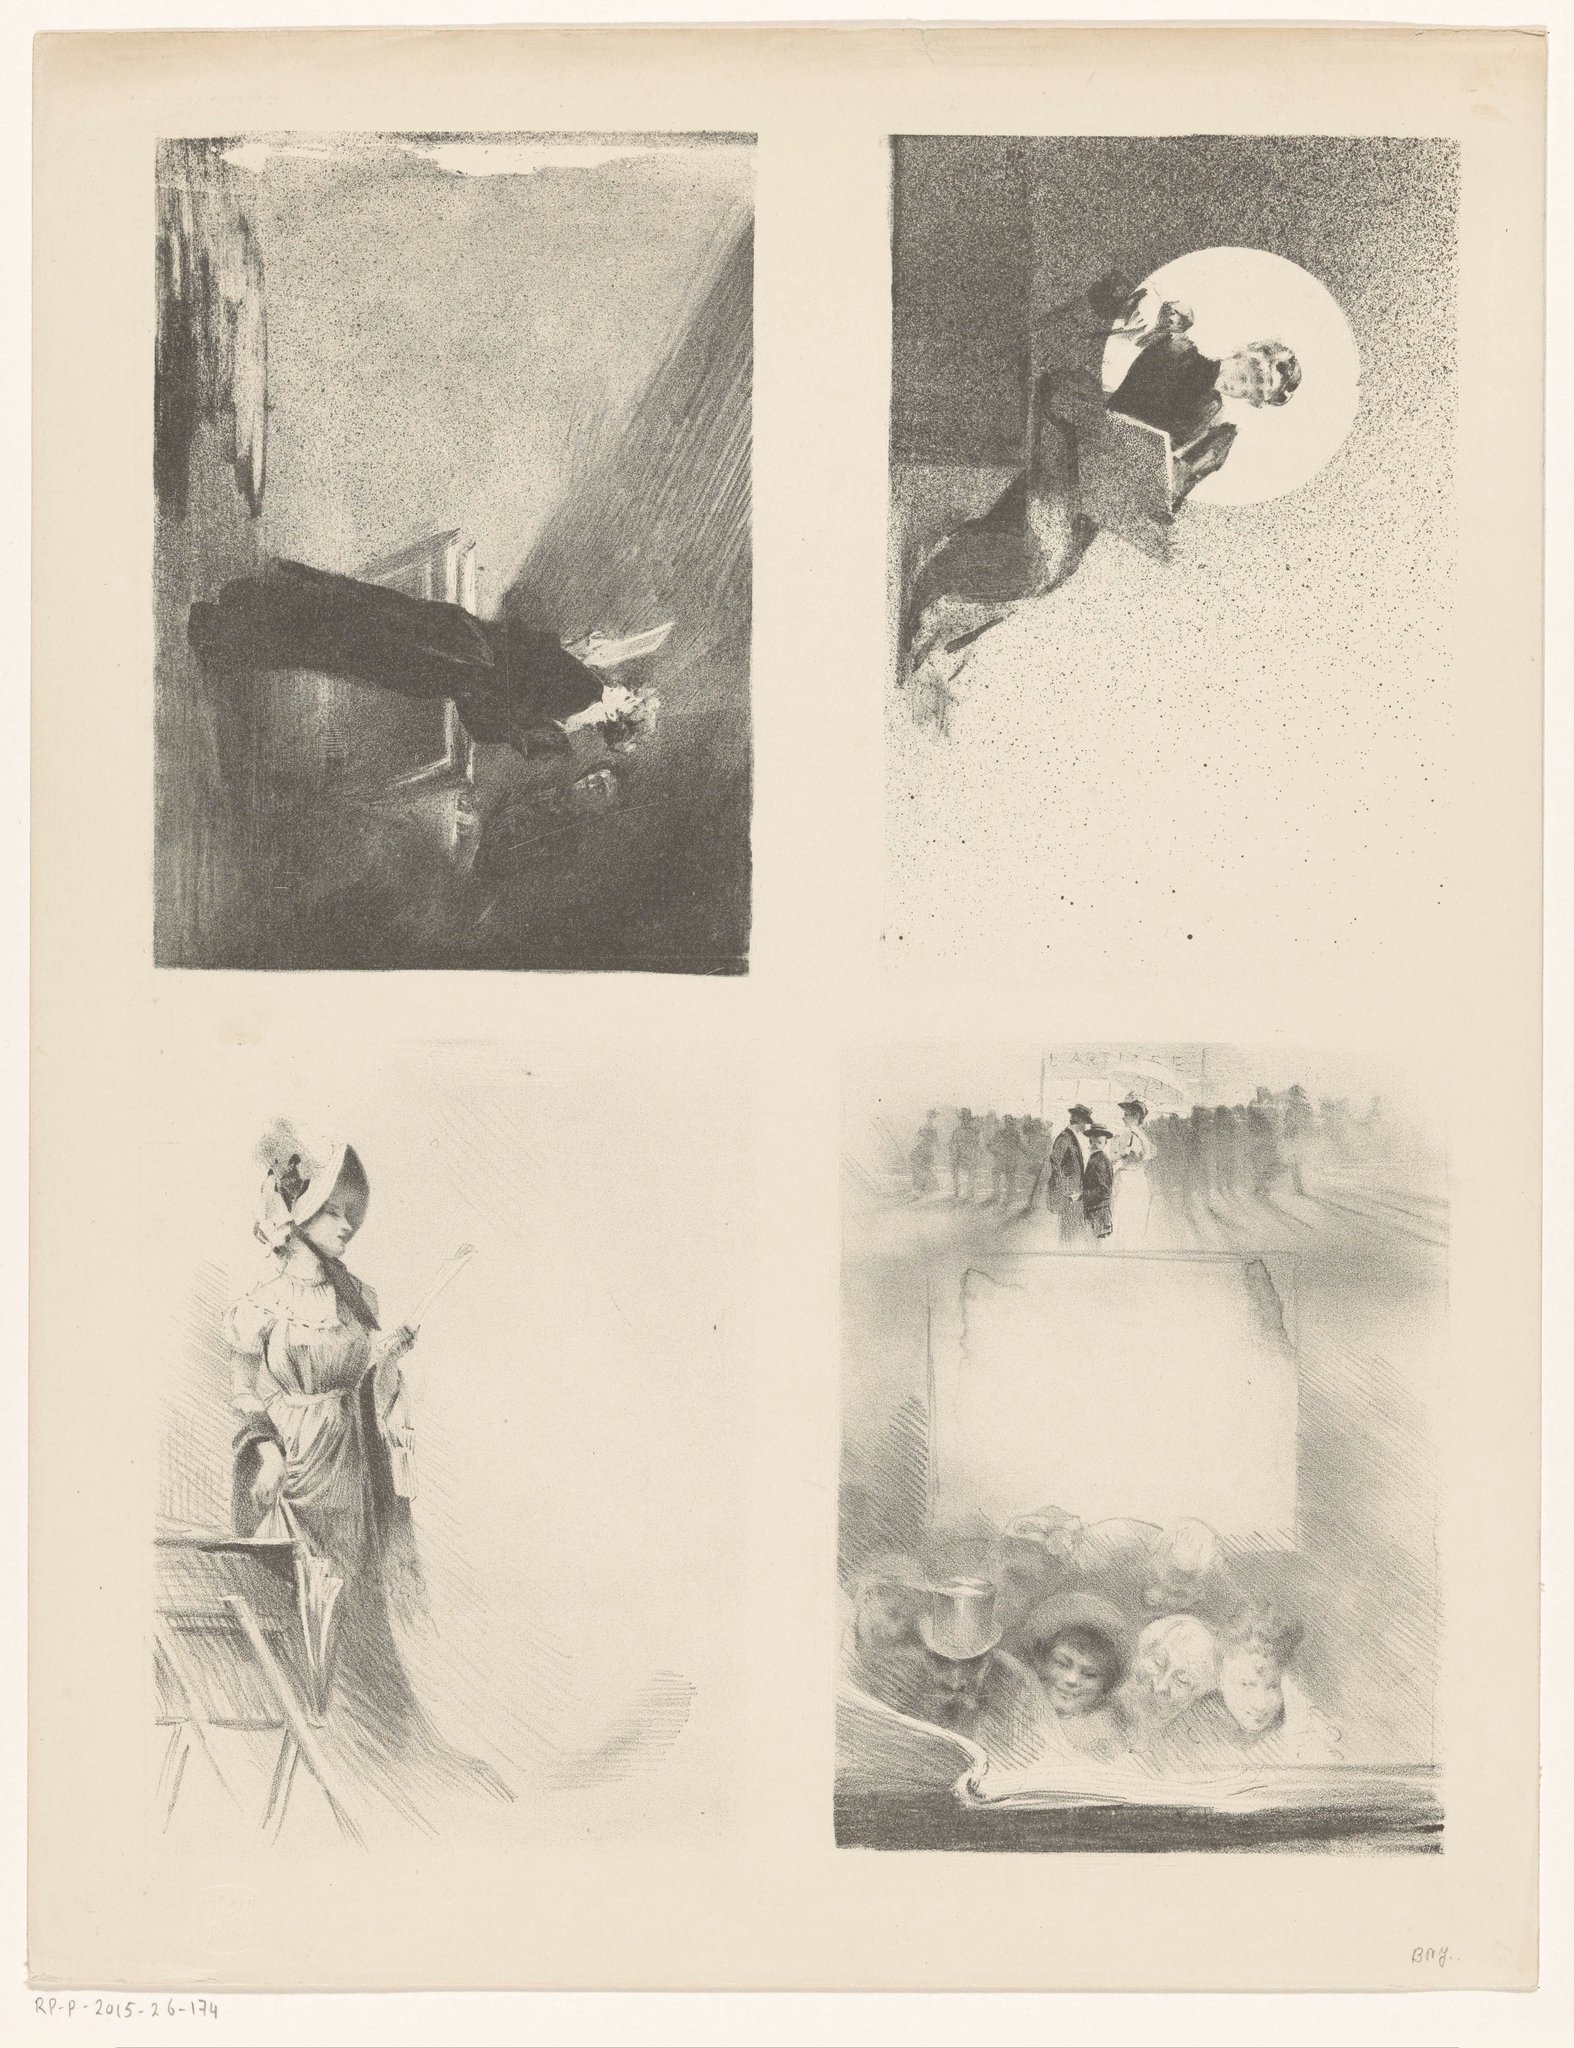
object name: print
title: Blad met vier scènes met naar prenten kijkende mensen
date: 1880-1900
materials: paper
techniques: lithograph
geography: paris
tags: drawing, book in which illustrations are essential - mm - book open, art collecting, shop-window, show-window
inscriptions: collector's mark: Lugt 2228, check stamp: Lugt 2254, collector's mark: Lugt 4780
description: Blad met vier scènes: een vrouw die een prent bekijkt naast een prentstandaard, een tekenende vrouw, een vrouw die een prent bekijkt naast een prentstandaard en figuren over een album gebogen met daarboven mensen voor een etalage.